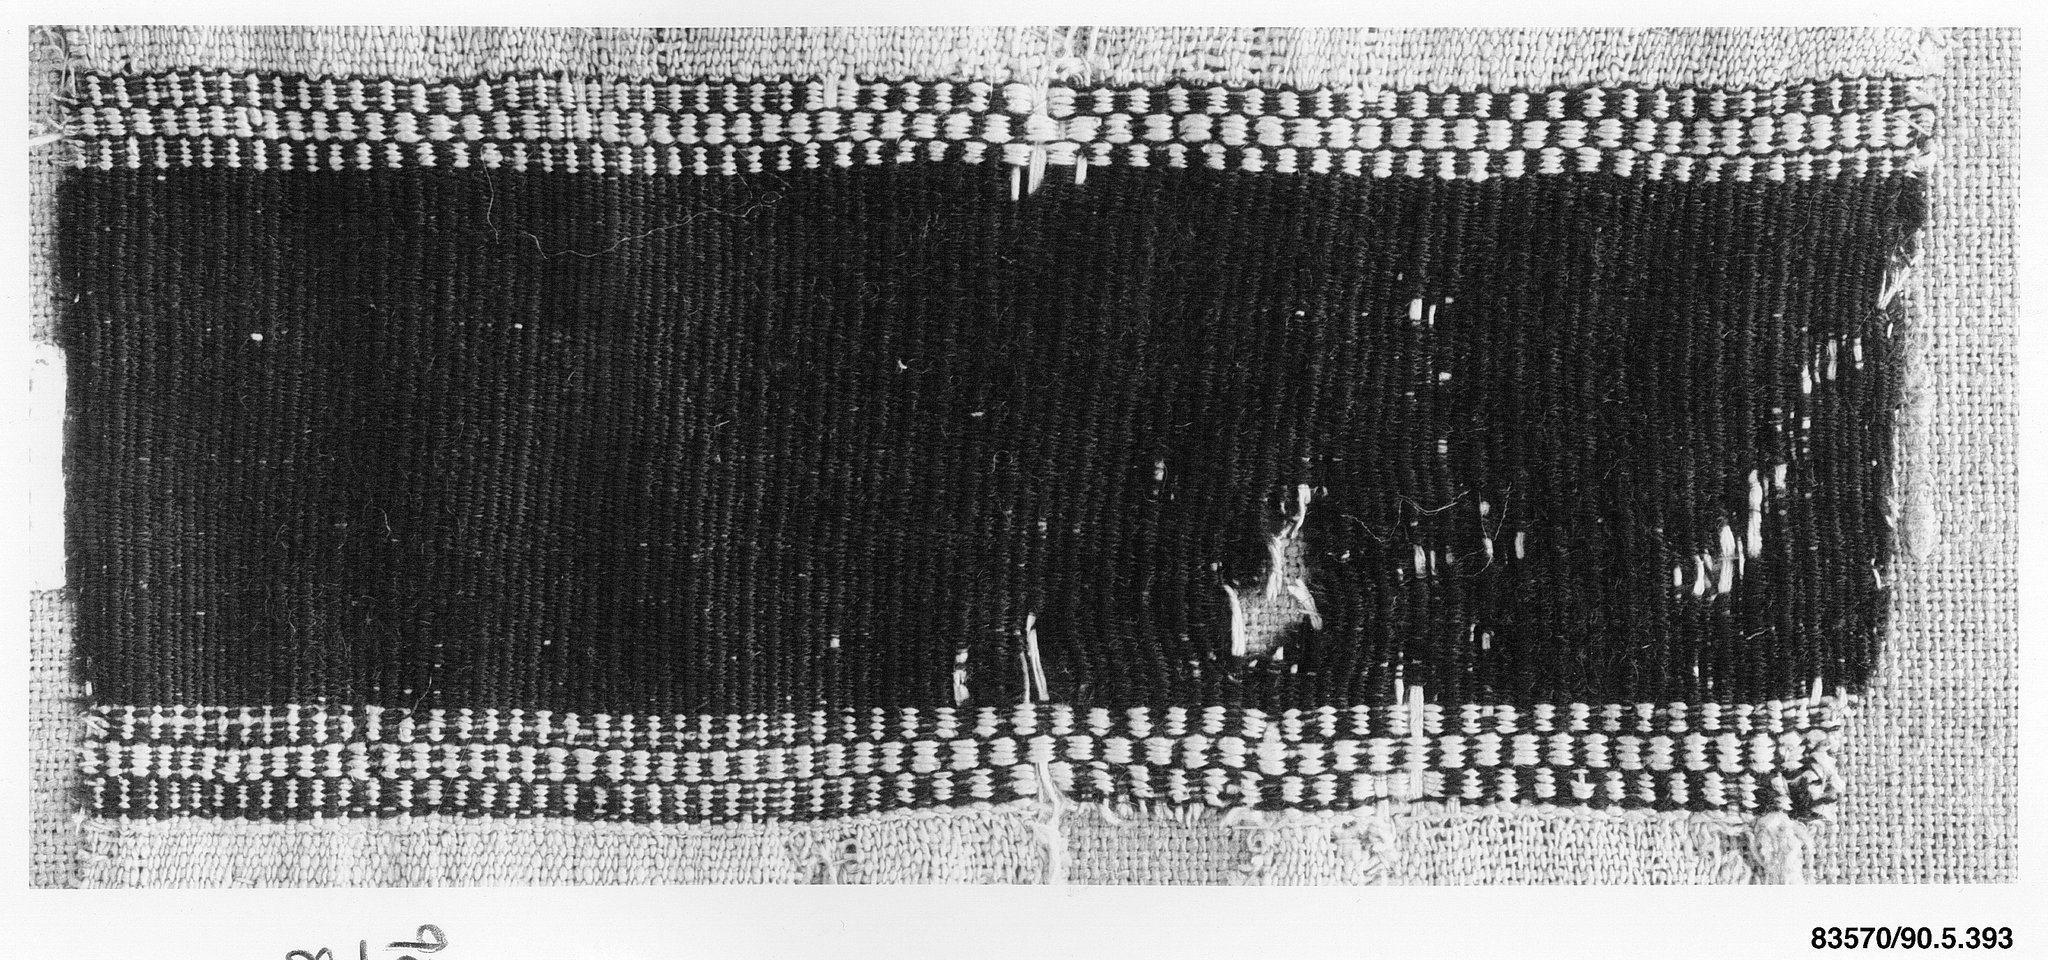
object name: textile fragment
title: Fragment of a Shoulder Band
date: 201-300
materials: linen, wool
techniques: weave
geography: egypt